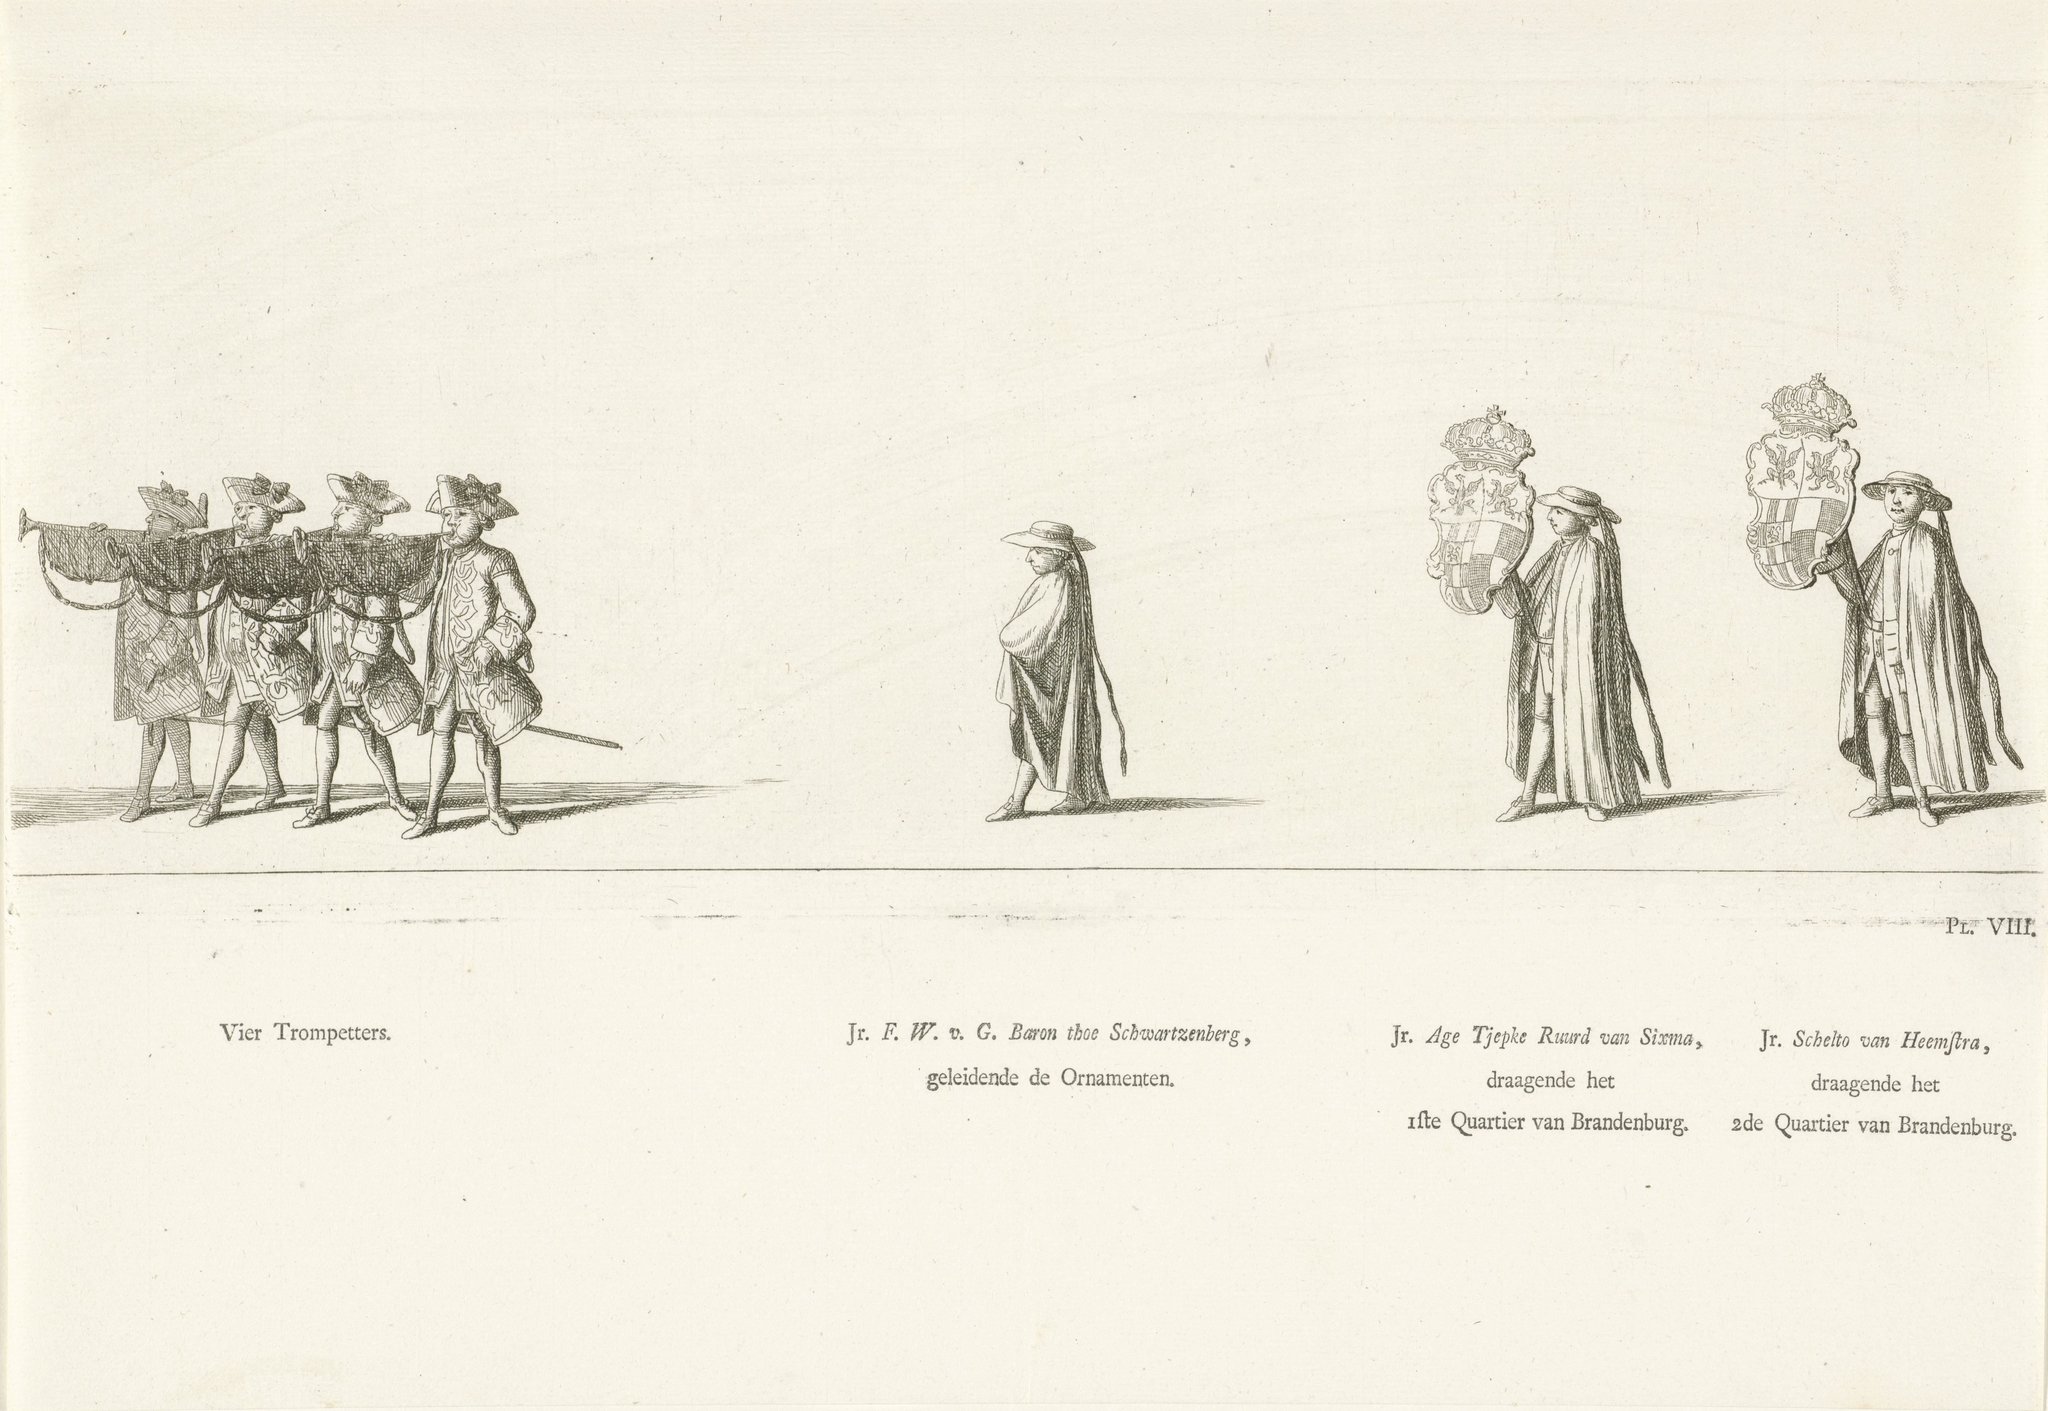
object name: print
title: Lijkstatie van prinses Maria Louise, 1765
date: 1765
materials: paper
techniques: etching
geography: leeuwarden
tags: military music, cortege, funeral procession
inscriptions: collector's mark: Lugt 2228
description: Vier trompetters gevolgd door edelen met de kwartieren van het stadhouderlijk wapen. Gemerkt rechtsonder: Pl. VIII. Op het blad onder de plaat de namen van personen in de stoet. Onderdeel van de serie platen van de begrafenis van prinses Maria Louise te Leeuwarden op 13 juni 1765.